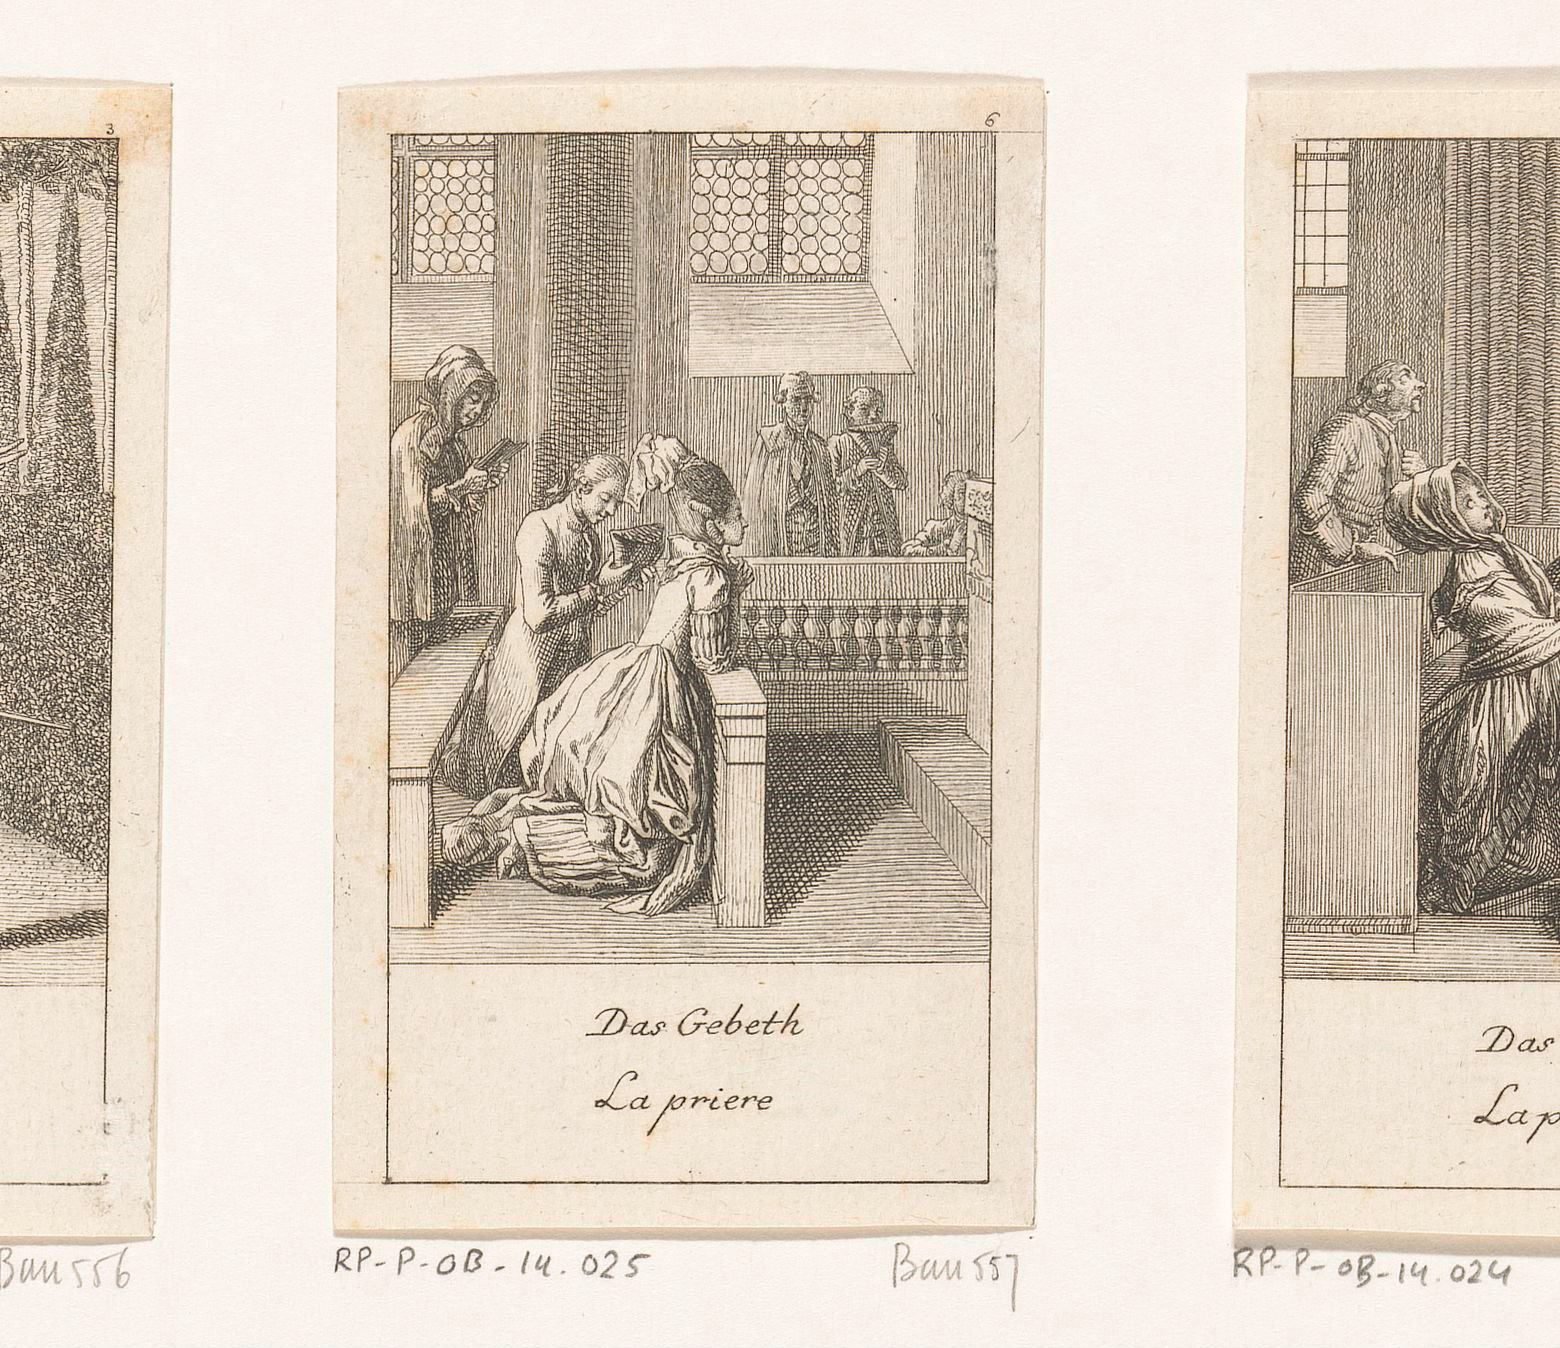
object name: print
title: Biddende kerkgangers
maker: daniel nikolaus chodowiecki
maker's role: draughtsman, print maker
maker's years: 1726-1801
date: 1778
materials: paper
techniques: etching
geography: berlin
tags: physicist, interior of church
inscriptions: collector's mark: Lugt 2228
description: Zesde prent uit een serie van twaalf taferelen die 'Natürliche und affectirte Handlungen des Lebens' (eerste serie) illustreren waarin 'natuurlijk' en 'geaffecteerd' gedrag op karikaturale wijze tegenover elkaar worden gezet. Deze taferelen zijn op een plaat geëtst. Deze serie, voorzien van toelichtingen door Georg Christoph Lichtenberg, is ook gebruikt in: Goettinger Taschen Calender vom Jahre 1779. Göttingen: Johann Christian Dieterich.